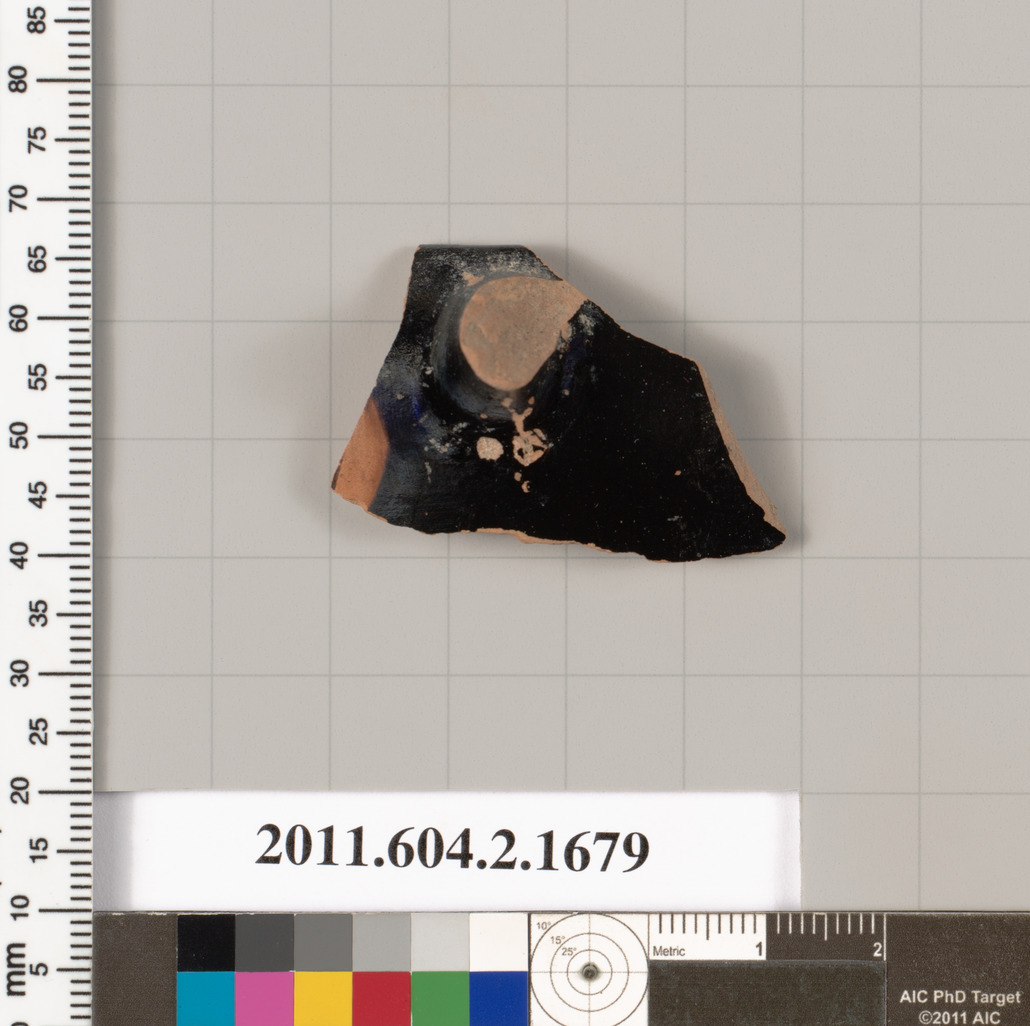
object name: skyphos fragment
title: Terracotta rim fragment of a skyphos (deep drinking cup)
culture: greek, attic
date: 450-401 BCE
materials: terracotta